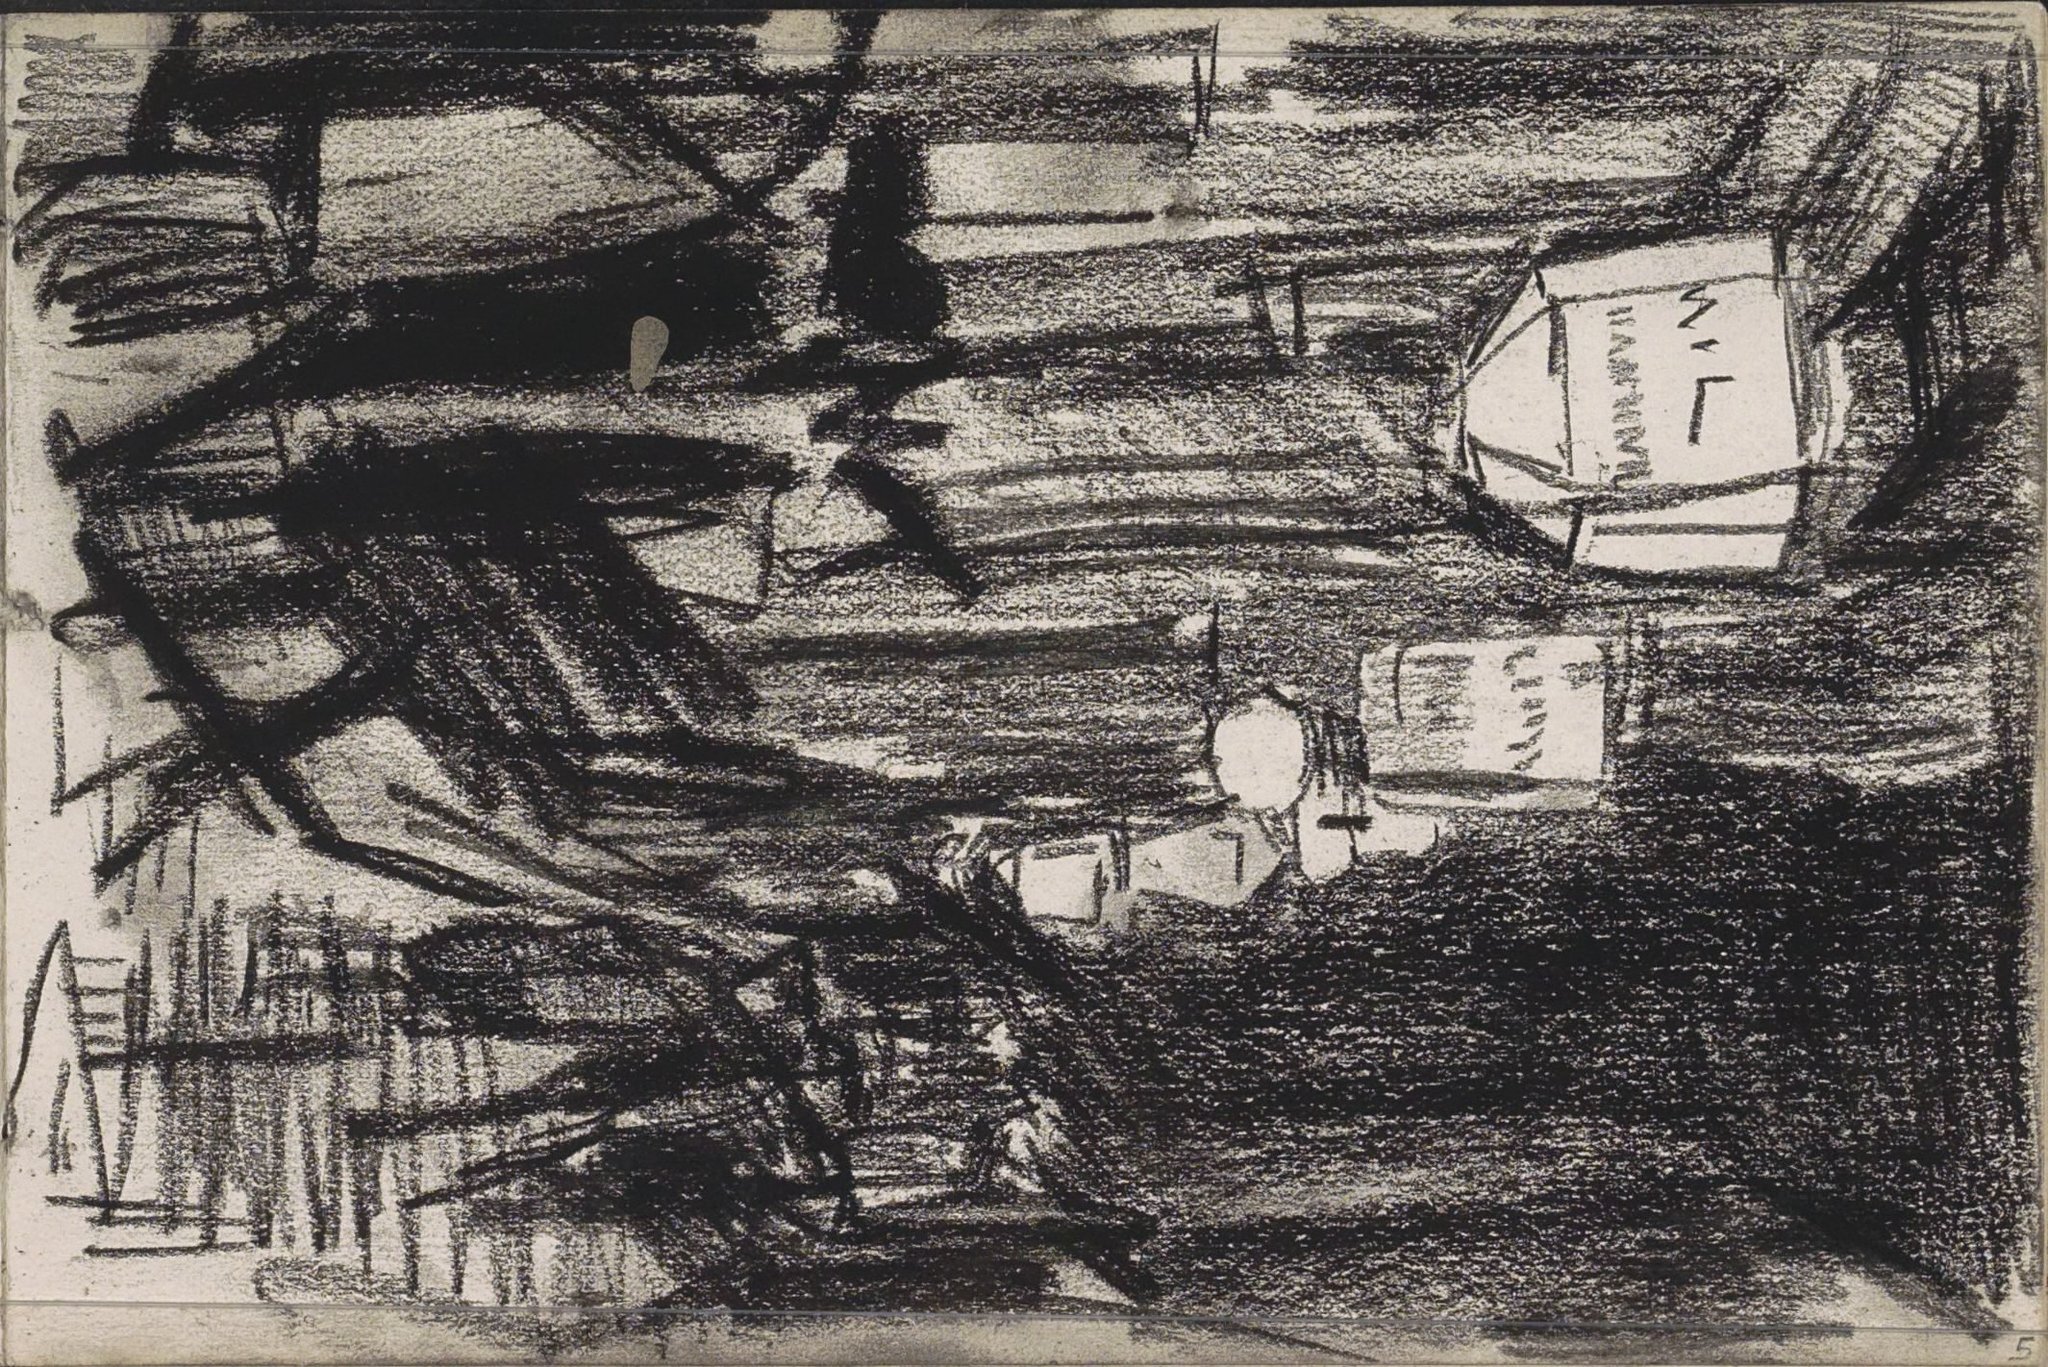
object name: sketchbook leaf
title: Figuren in een straat met lantaarns, bij nacht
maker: isaac israels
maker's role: draughtsman, painter, print maker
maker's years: 1865-1934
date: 1875-1934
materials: chalk, paper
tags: street lighting, street (+ city(-scape) with figures, staffage)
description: Blad 5 recto uit schetsboek LIII met 10 bladen.